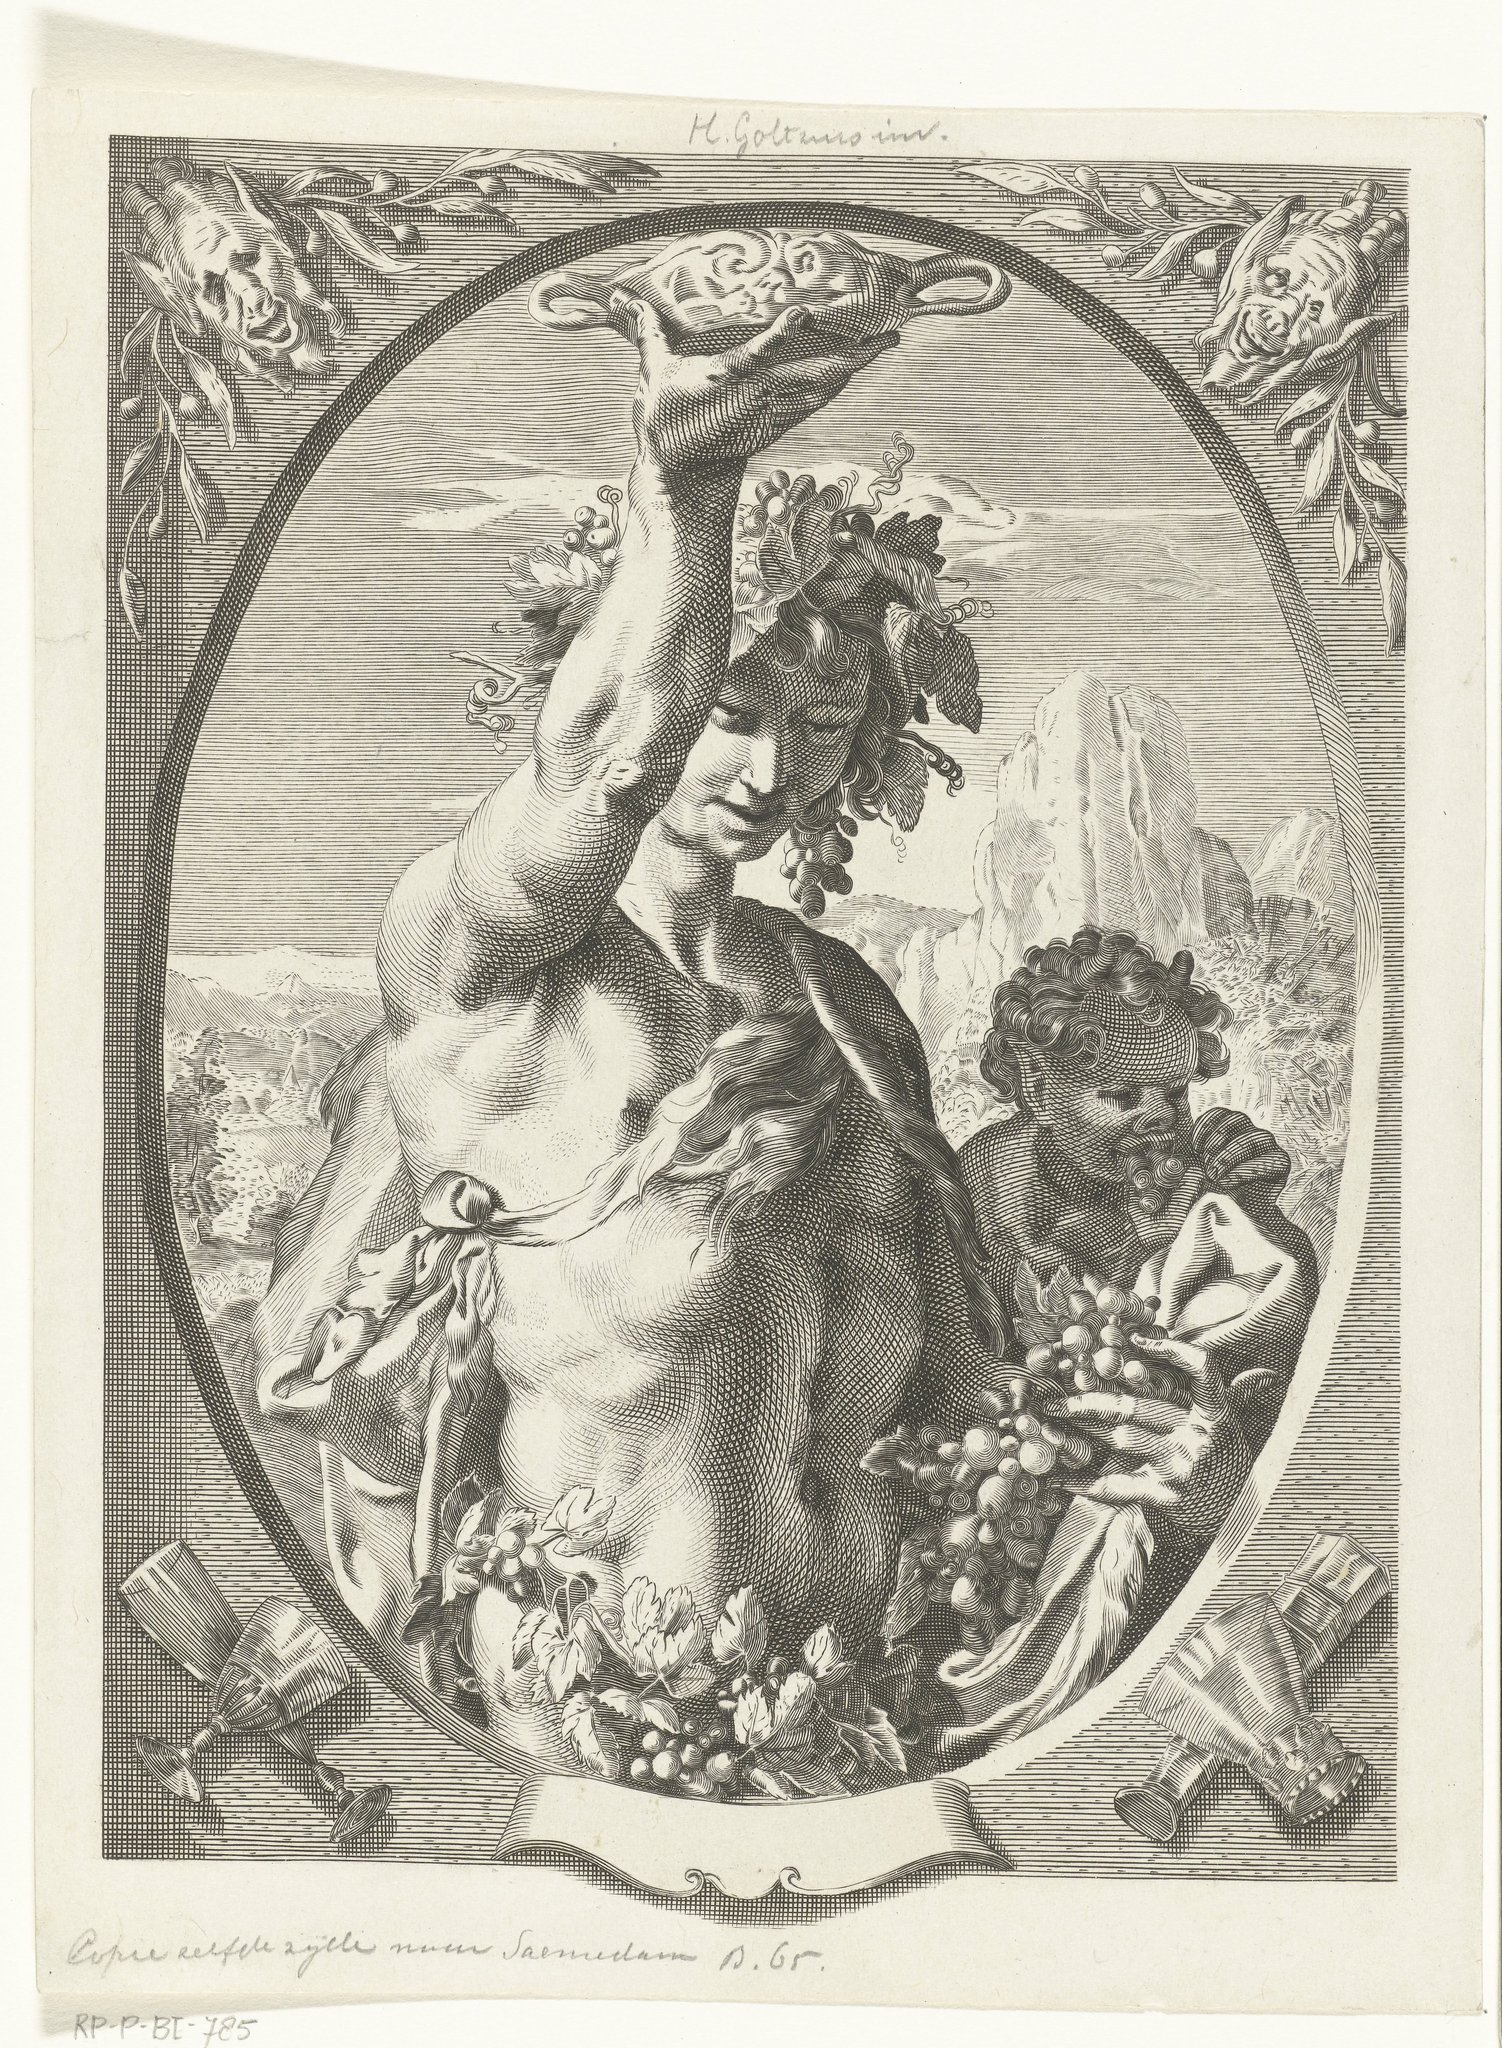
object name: print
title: Bacchus met drinkschaal en druiventrossen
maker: johannes cornelis bell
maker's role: print maker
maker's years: 1822-1907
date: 1832-1907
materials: paper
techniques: engraving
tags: (story of) bacchus (dionysus), liber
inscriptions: collector's mark: Lugt 2228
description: Kopie naar prent van Jan Saenredam. Het originele ontwerp voor deze Bacchus komt van Hendrick Goltzius.